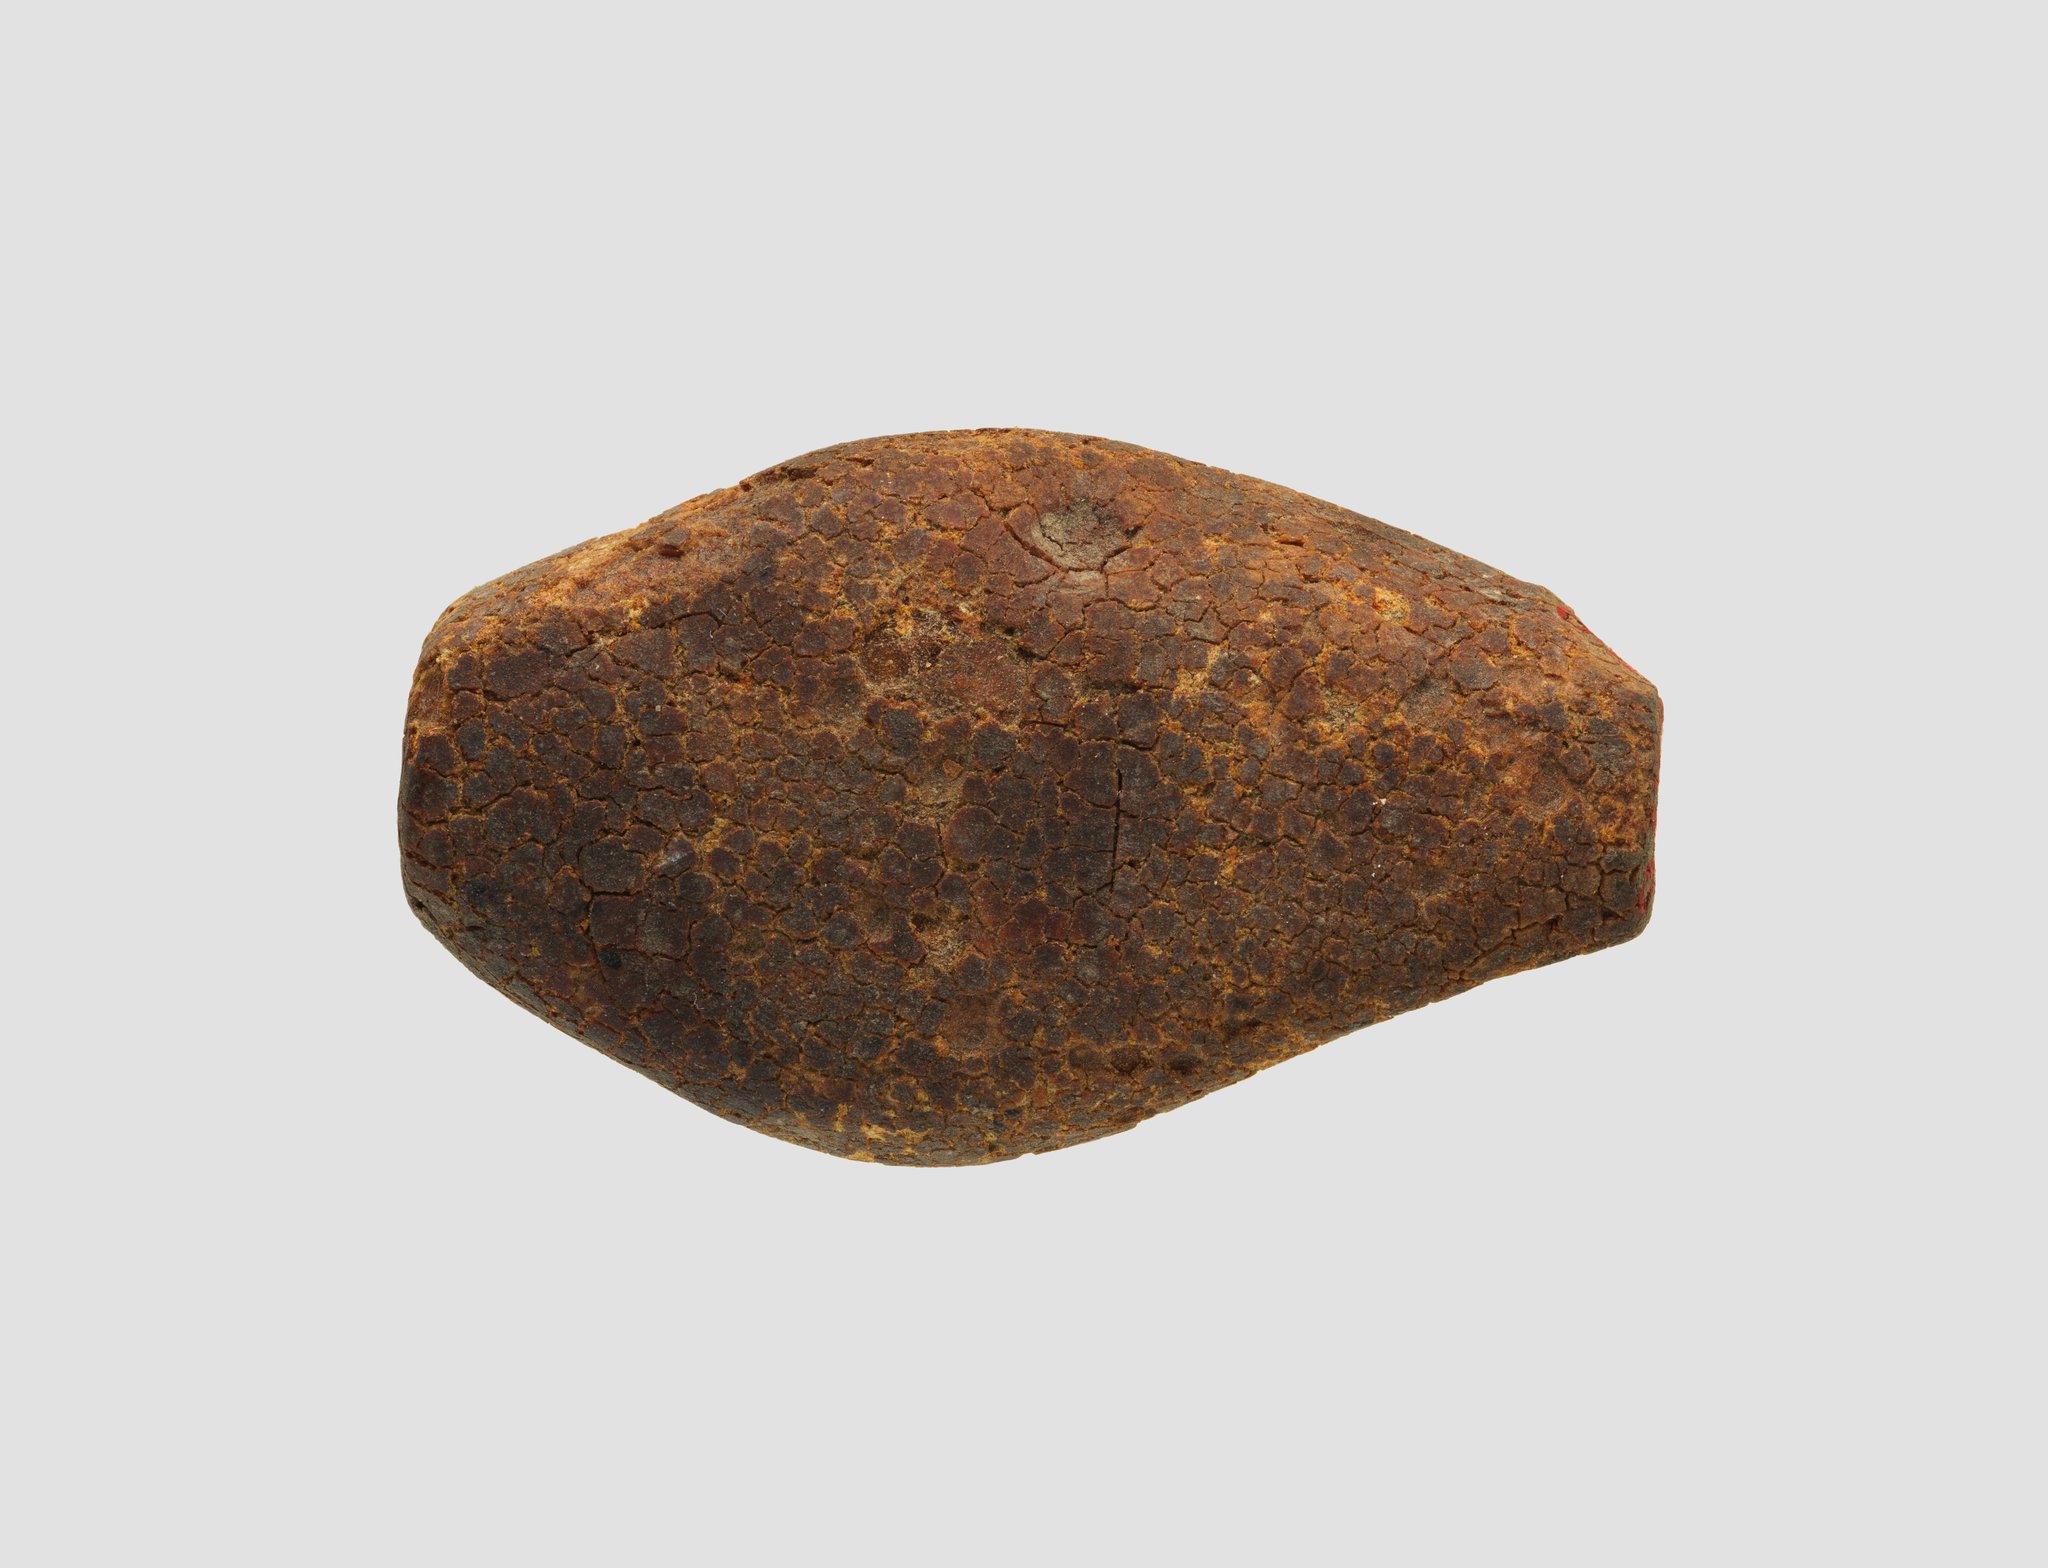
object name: bead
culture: iranian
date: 900-801 BCE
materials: amber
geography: iran